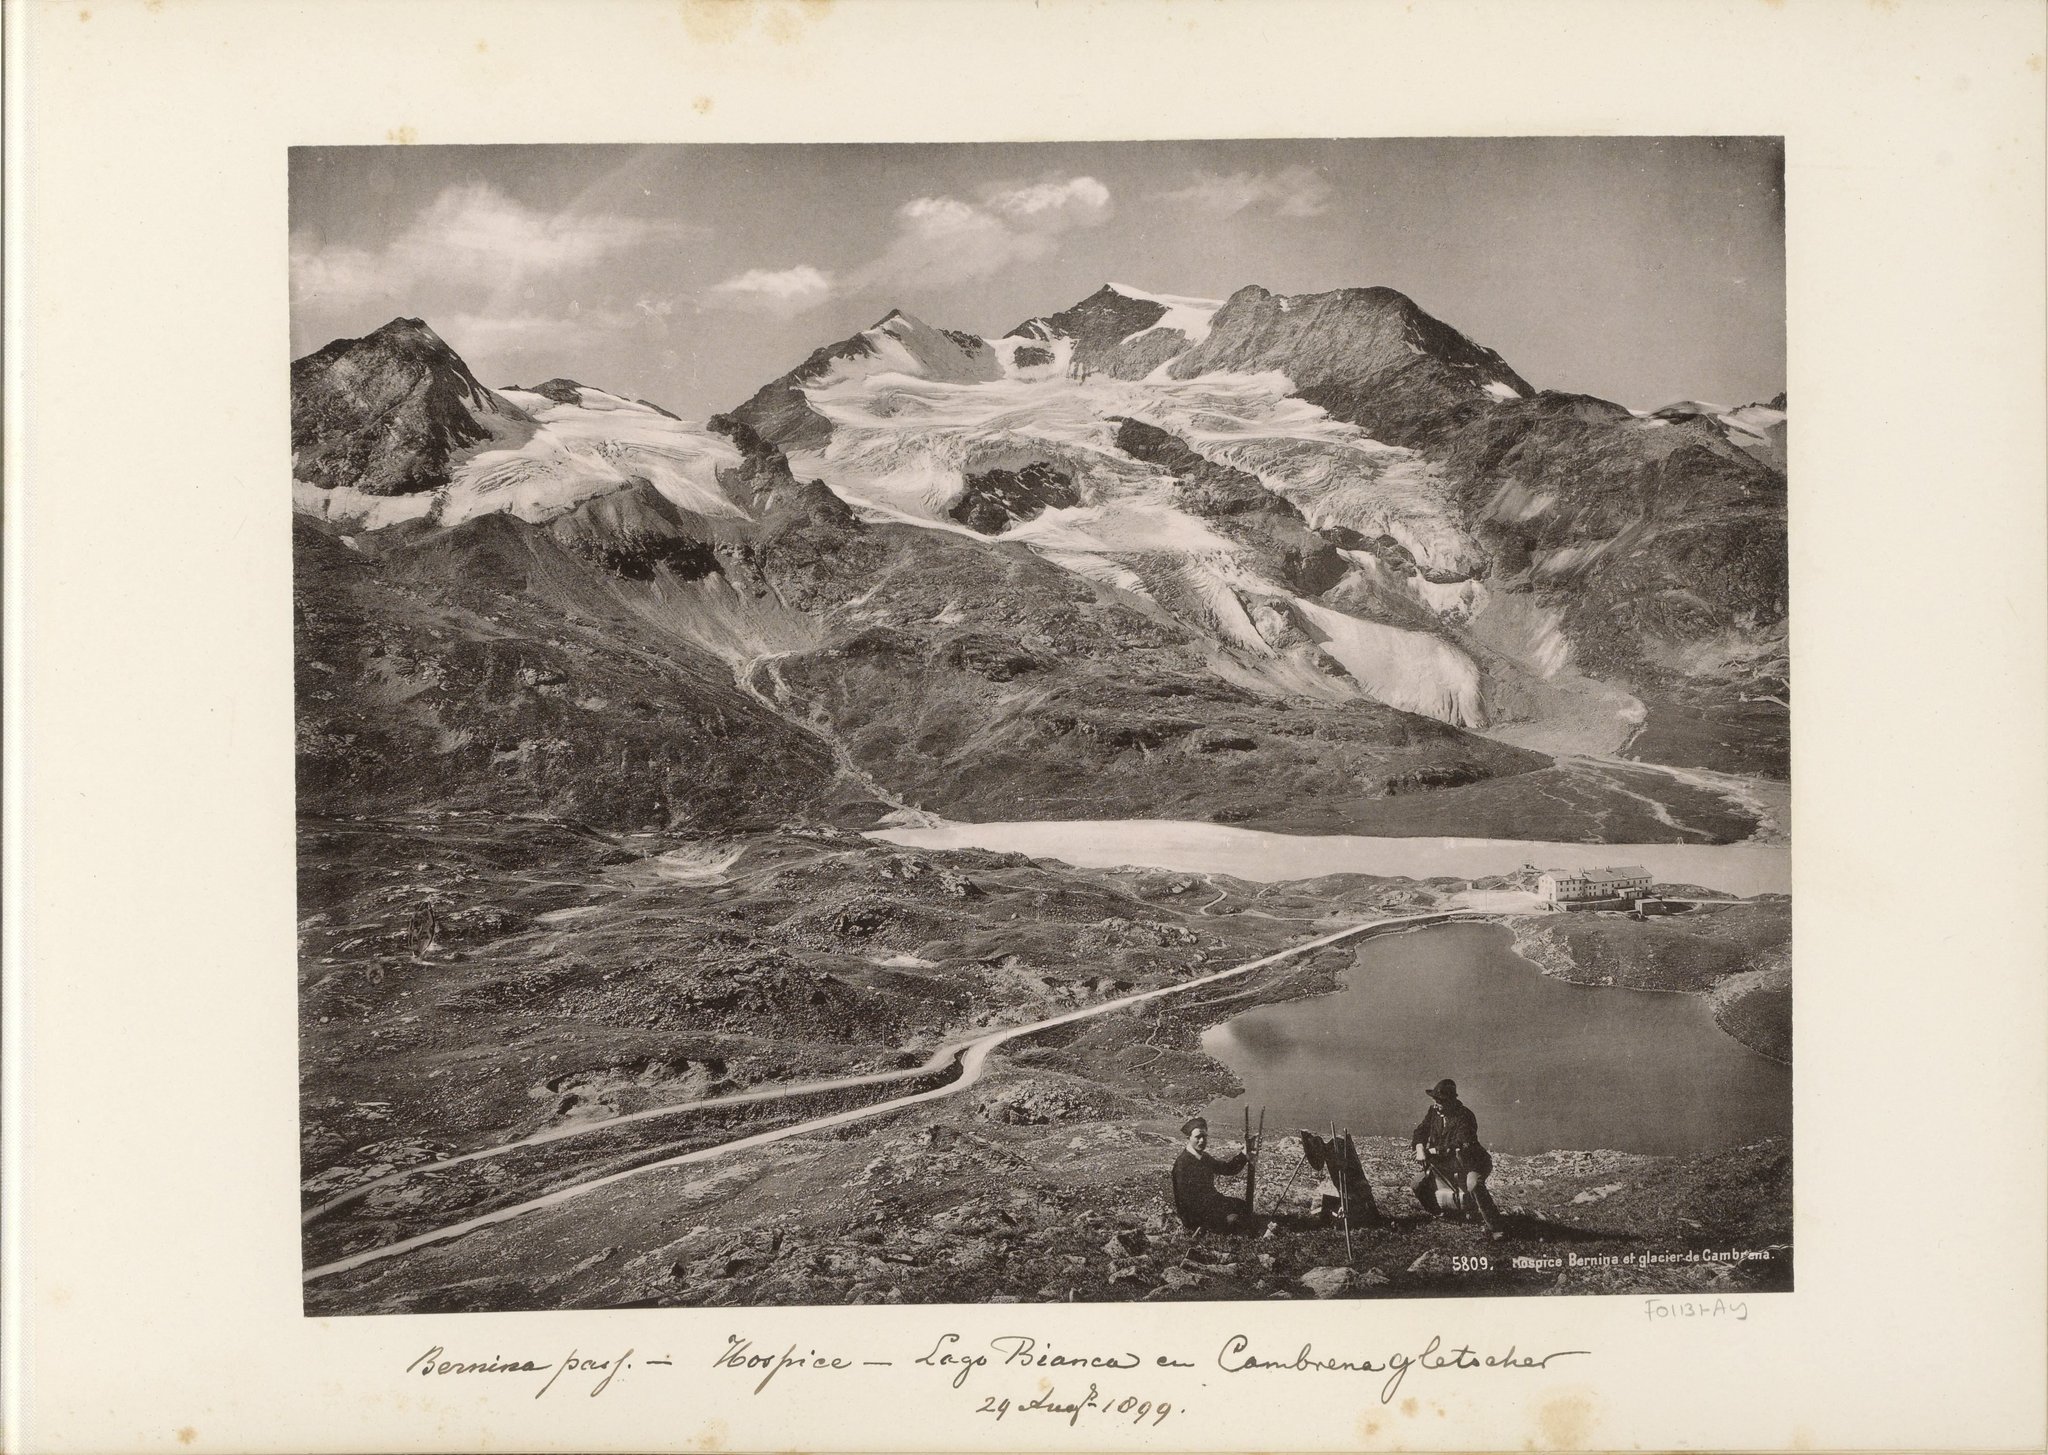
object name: photograph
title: Gezicht op de Cambrenagletsjer en de uitspanning Bernina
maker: Anonymous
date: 1880-1899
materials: paper, photographic support, ink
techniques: photograph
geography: graubunden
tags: glacier, hotel, hostelry, inn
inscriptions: number: ‘5809’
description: Onderdeel van Reisalbum met bezienswaardigheden in Duitsland, Oostenrijk, Zwitserland, Luxemburg en België.